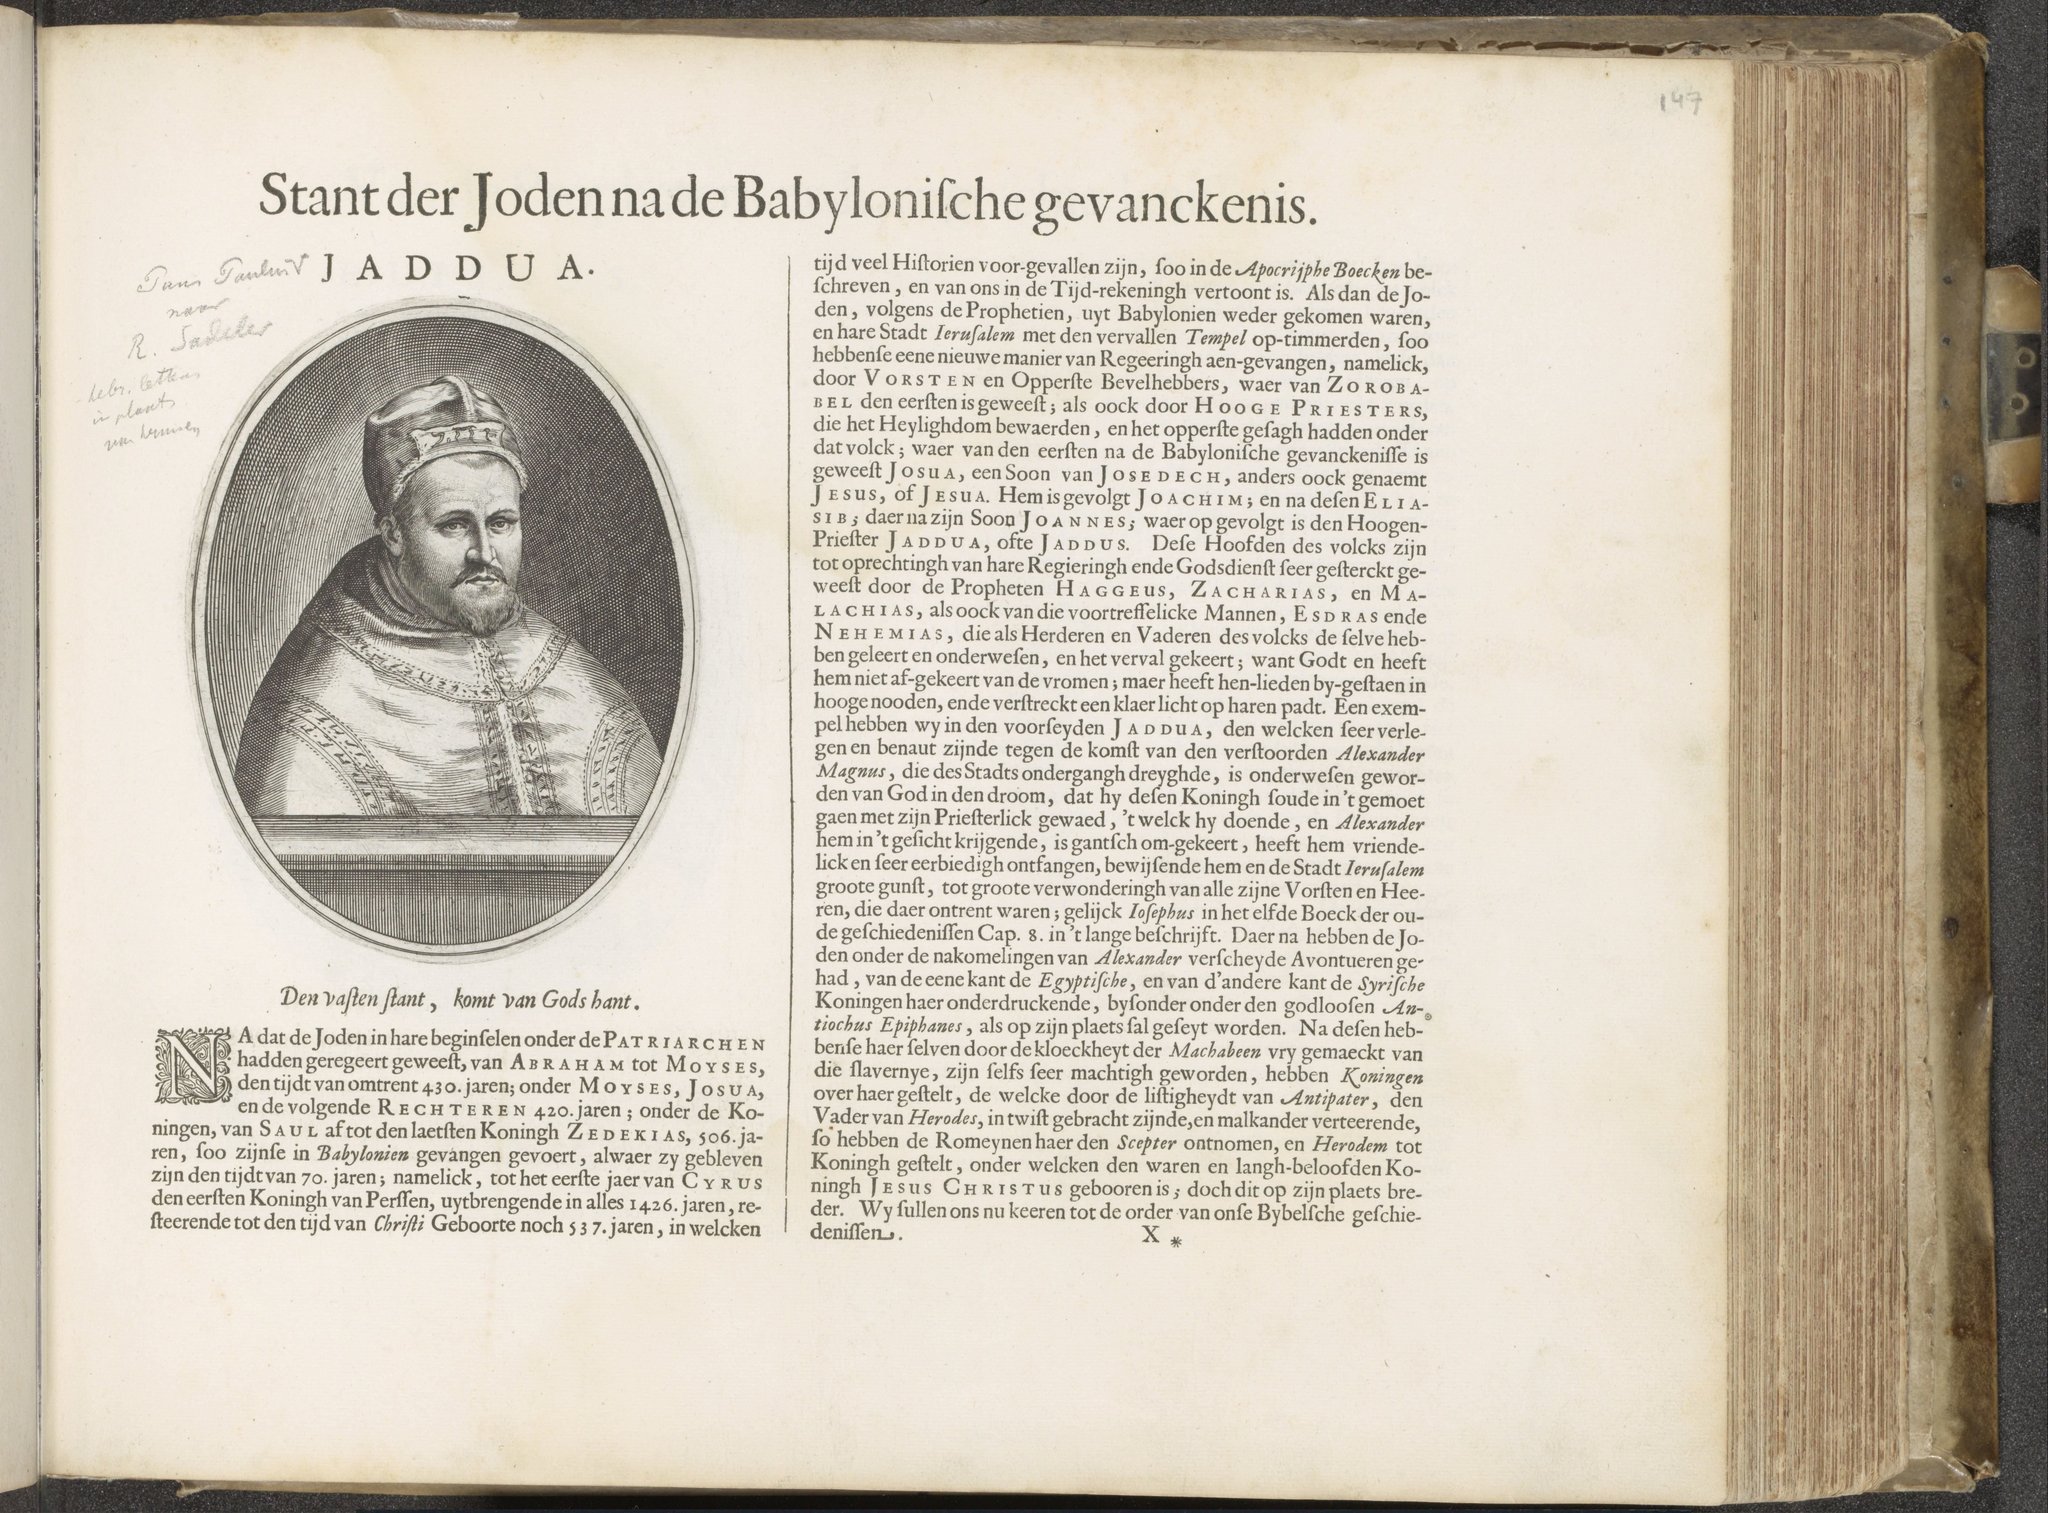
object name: album leaf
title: Stant der joden na de Babylonische gevanckenis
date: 1610-1625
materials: paper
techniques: engraving, letterpress printing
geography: amsterdam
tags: paulus v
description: Portret van paus Paulus V, in dit album gebruikt als afbeelding van de hogepriester Jaddua. De begeleidende tekst begint met een kleine gedecoreerde initiaal N. Het blad maakt deel uit van een album.